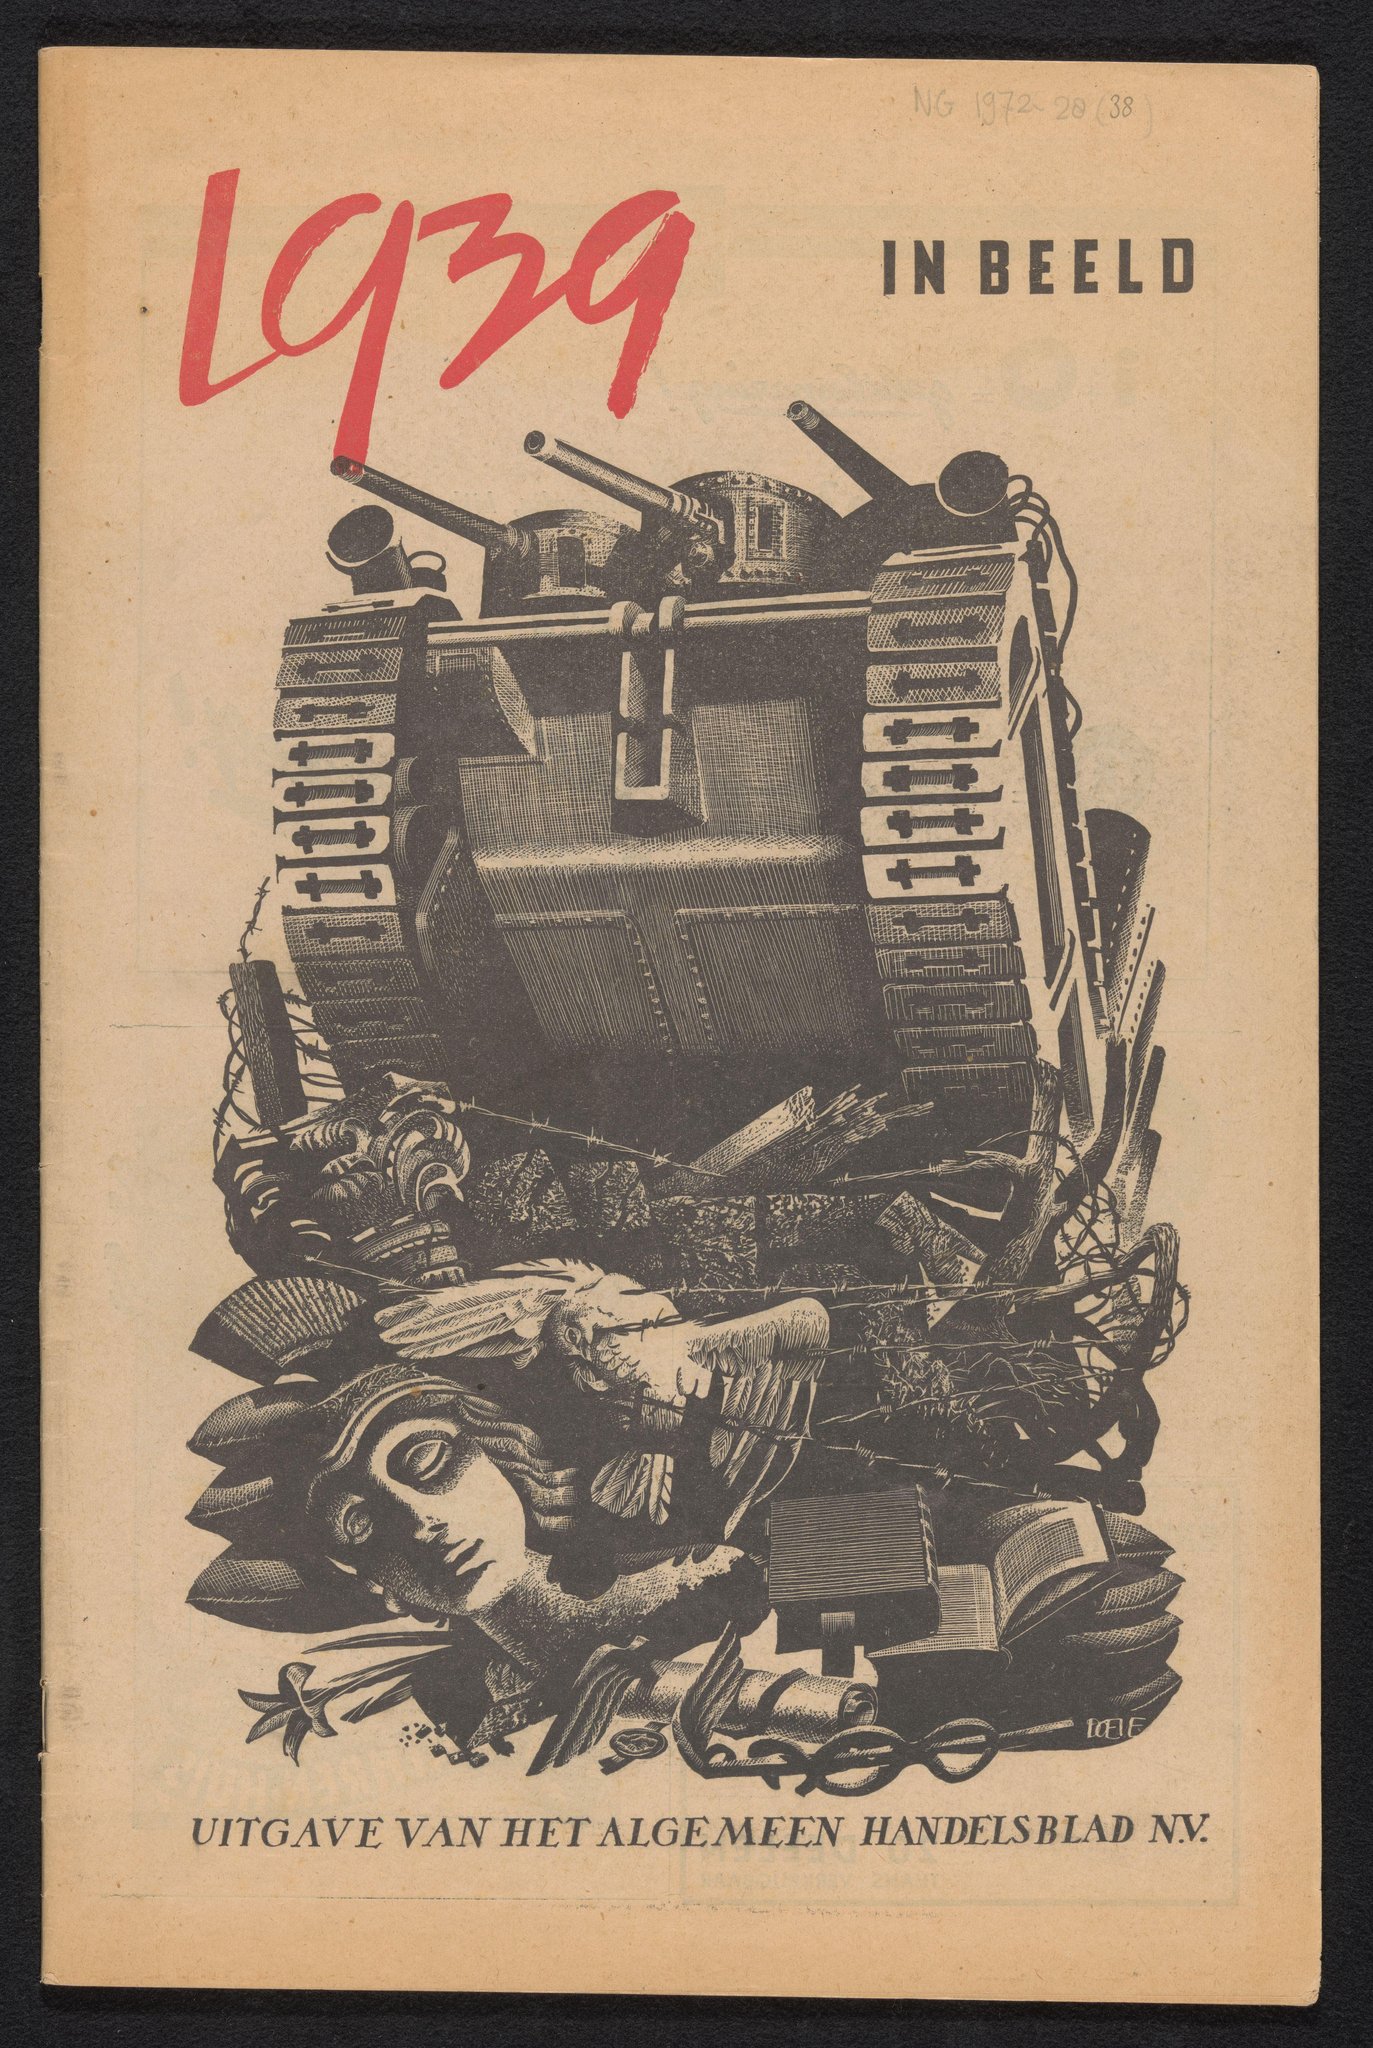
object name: supplement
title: 1939 in beeld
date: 1940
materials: paper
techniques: printing, stapling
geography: amsterdam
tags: netherlands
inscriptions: date